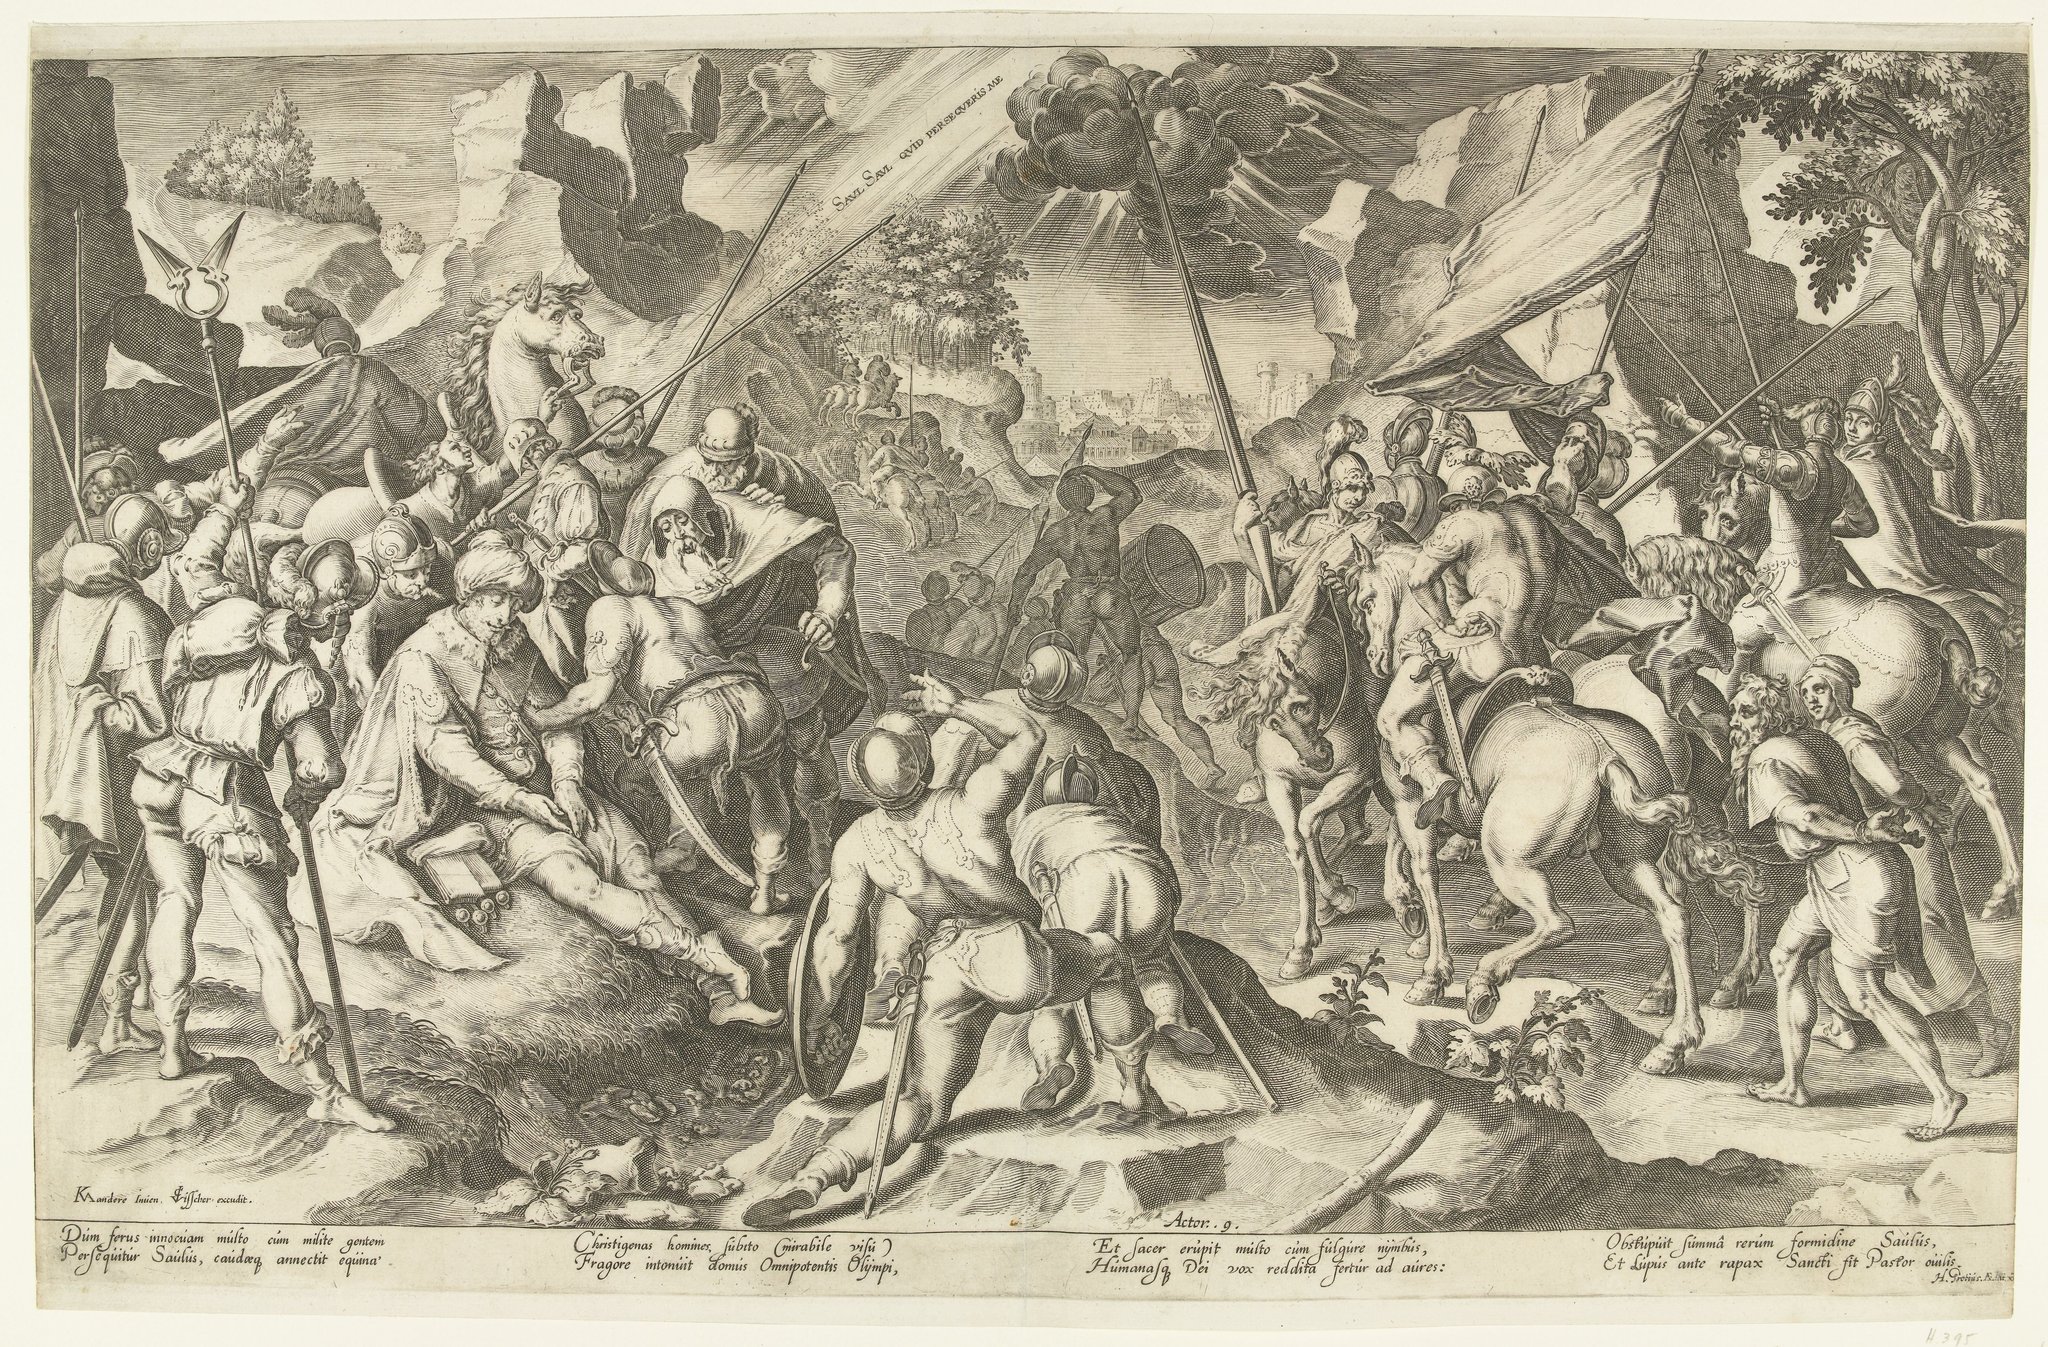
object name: print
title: De bekering van Paulus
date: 1595-1596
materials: paper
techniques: engraving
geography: netherlands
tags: on the way to damascus christ appears to saul, who falls from his horse and is blinded by the light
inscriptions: collector's mark: Lugt 2228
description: Een reisgezelschap in een berglandschap wordt opgeschrikt door een stem en fel licht uit de hemel (verbeeld door de tekst 'Savl Savl qvid persequeris me' in een lichtstraal). Links op de voorgrond zit Paulus op de grond nadat hij van zijn paard is gevallen; reisgezellen staan bezorgd om hem heen. Rechts op de voorgrond worden een man en een vrouw geboeid meegevoerd door een troep ruiters. Op de achtergrond is een stad zichtbaar. Onder de voorstelling een achtregelig Latijns gedicht.